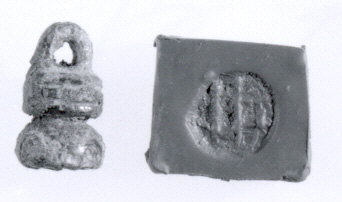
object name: stamp seal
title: Stamp seal (two-tiered bell with loop handle) with monster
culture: urartian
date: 800-601 BCE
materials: alloy, bronze, copper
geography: urartu